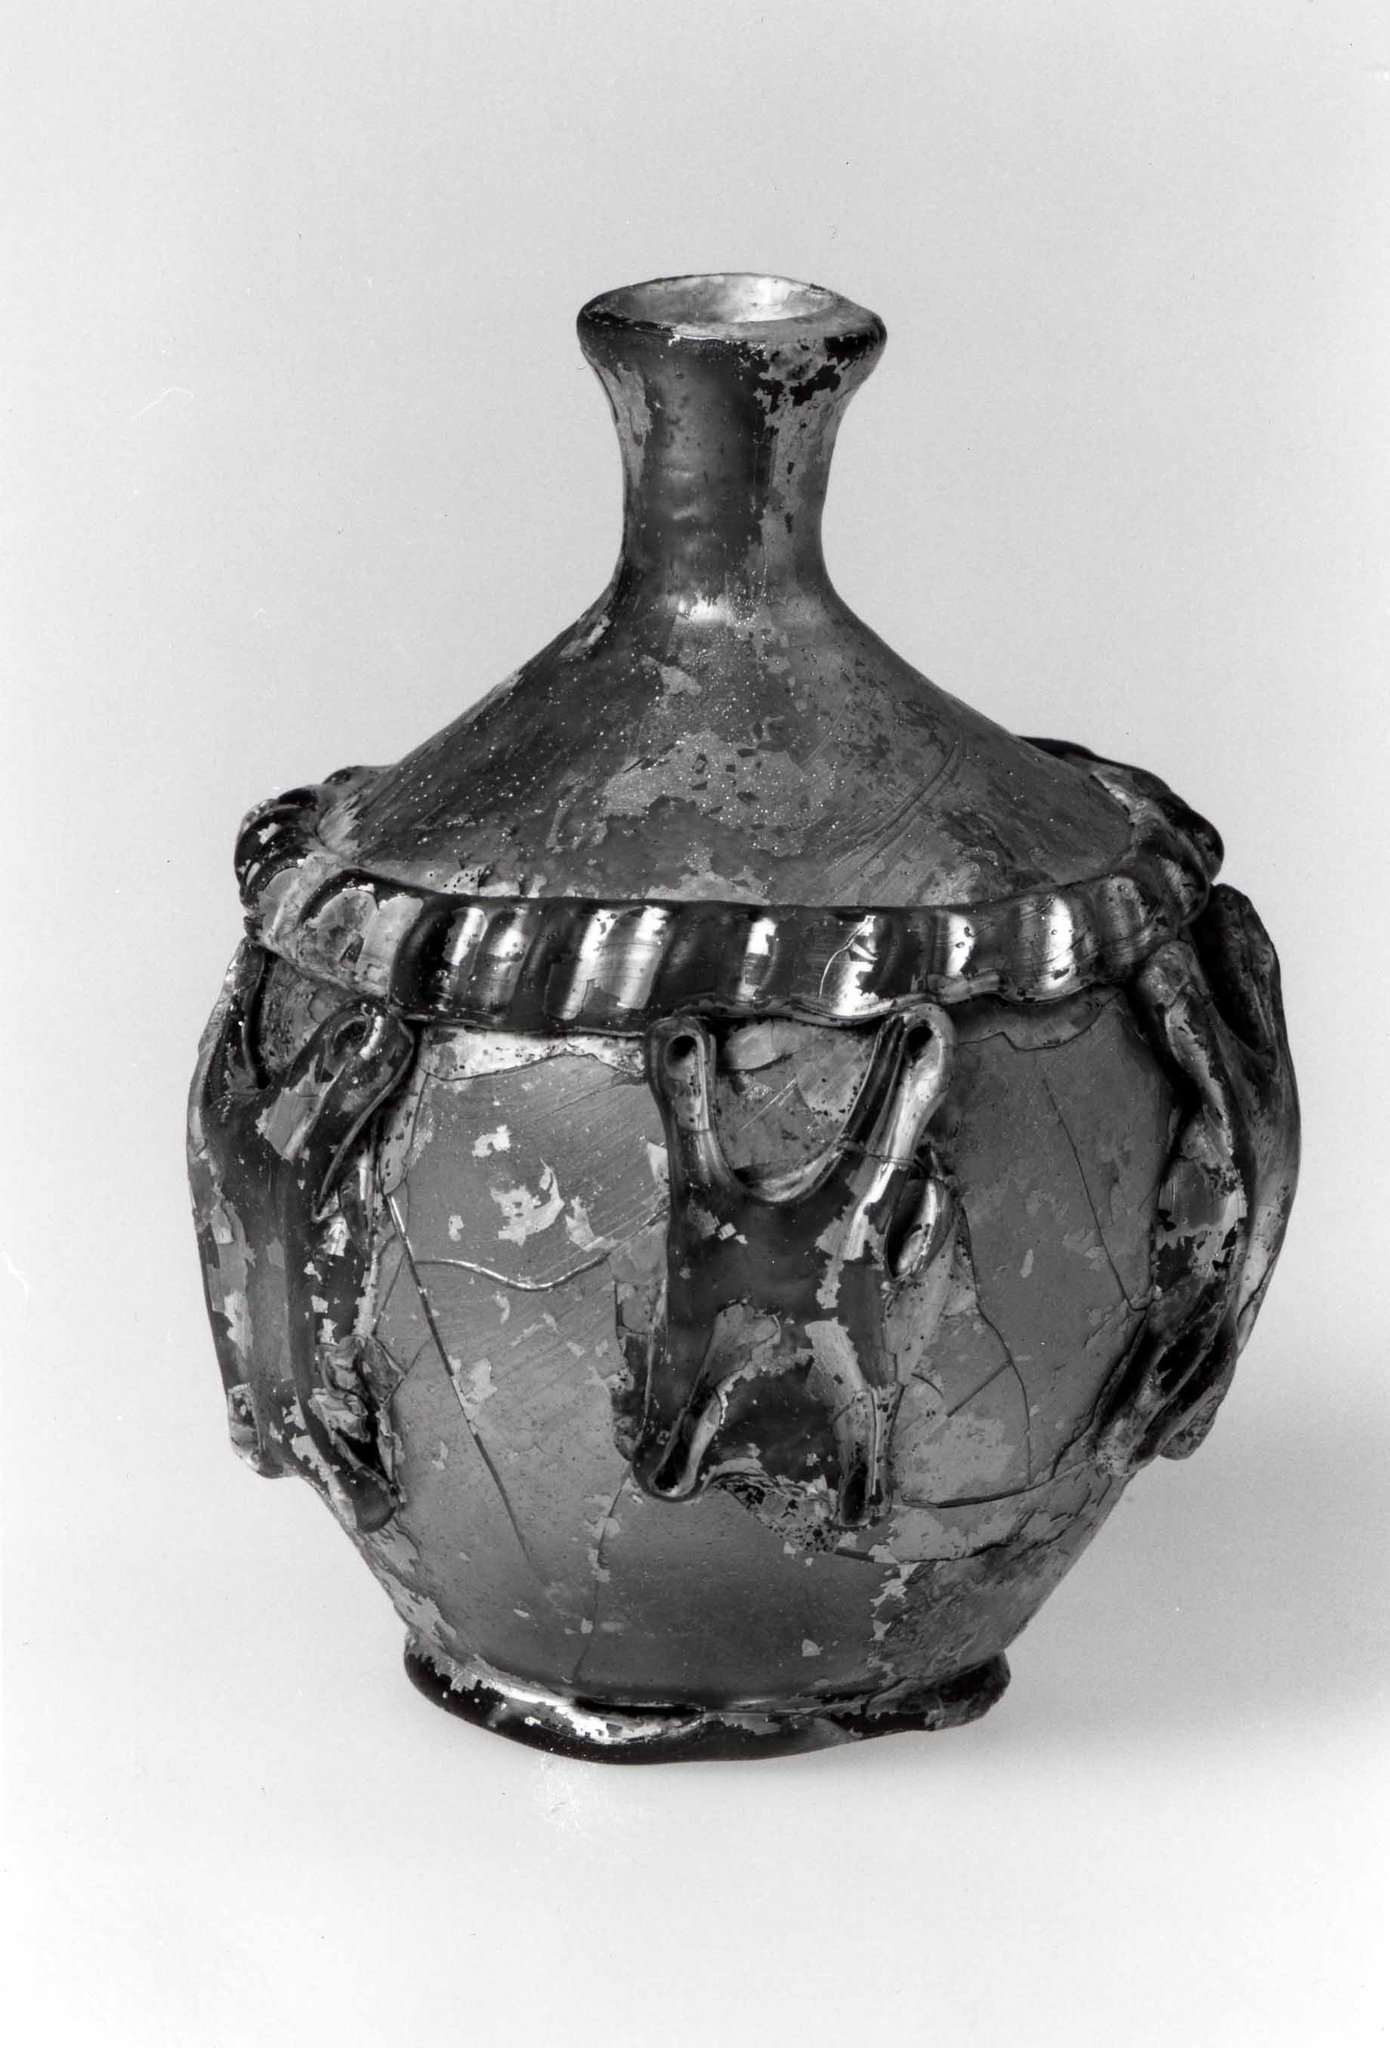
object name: flask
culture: islamic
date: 601-900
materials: glass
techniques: glassblowing, tooling